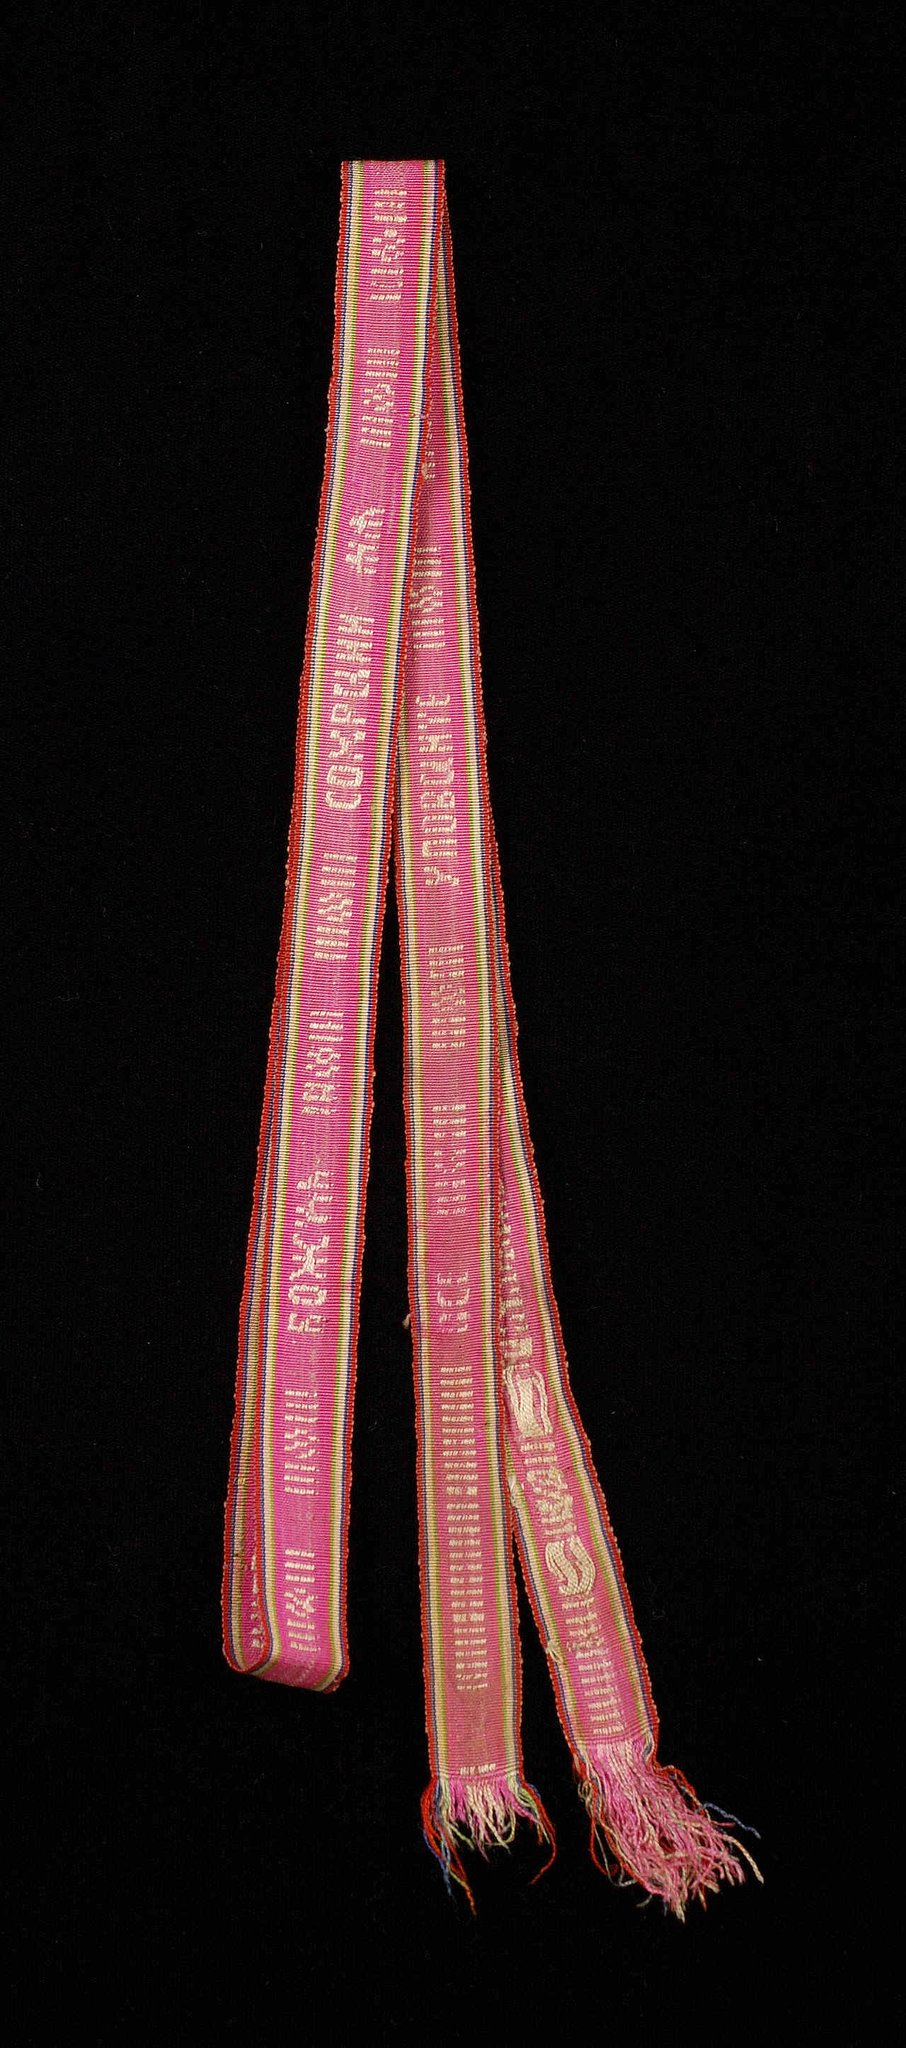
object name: sash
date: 1801-1900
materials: silk